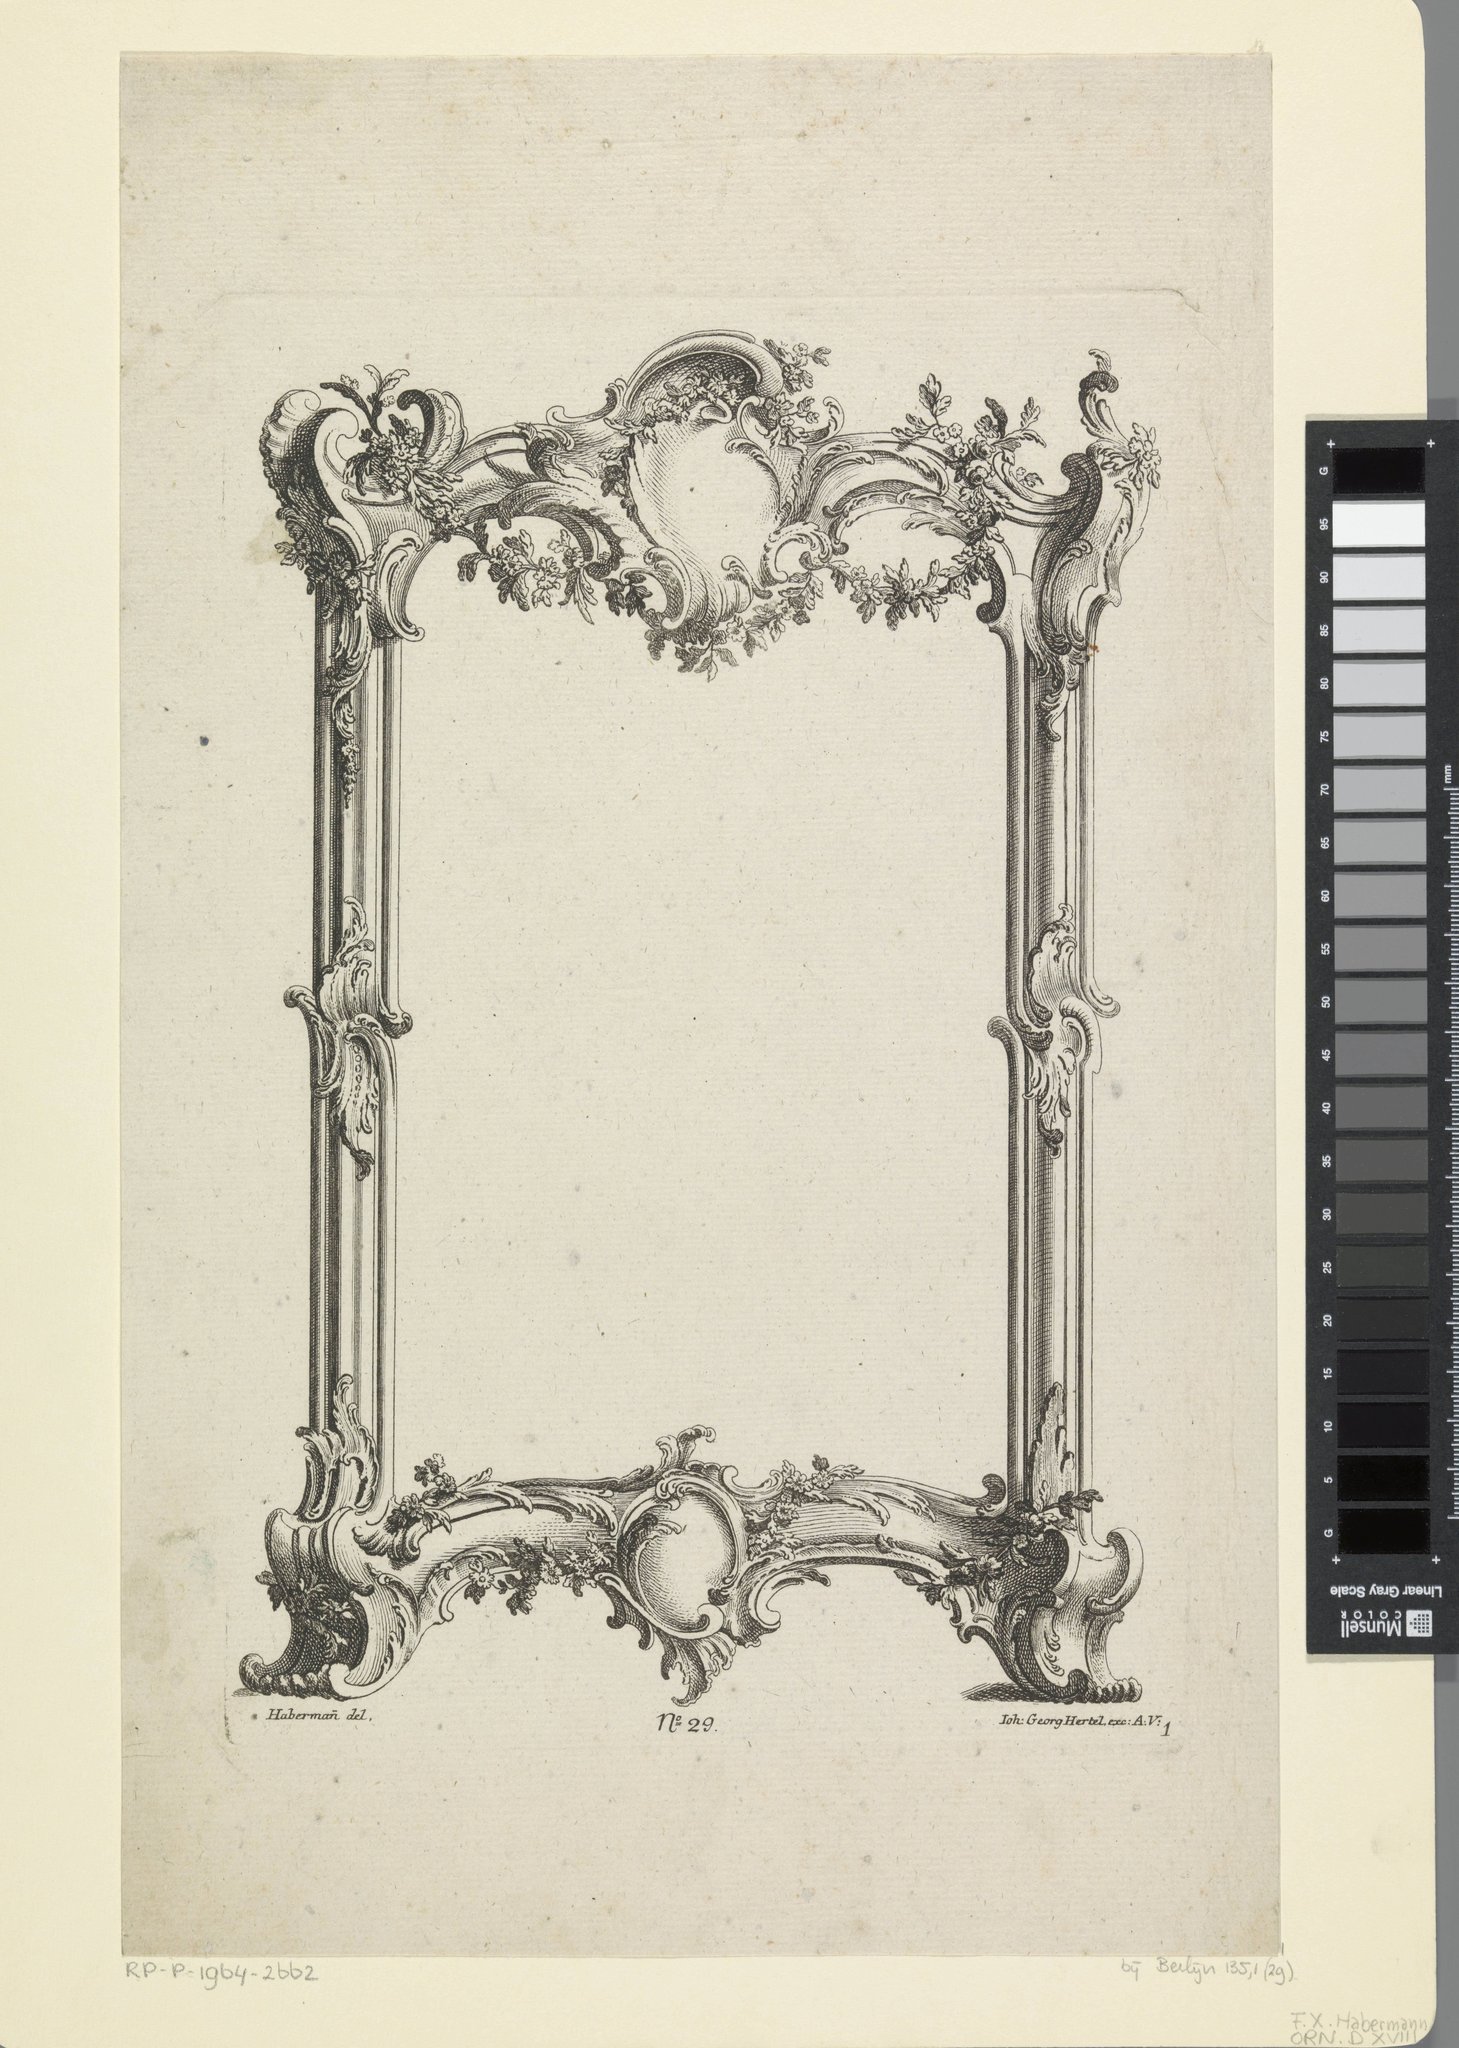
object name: ornament print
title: Rocaille lijst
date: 1731-1775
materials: paper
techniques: etching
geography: augsburg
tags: rocaille ornament, ornaments ~ art (+ framing decorations)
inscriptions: collector's mark: Lugt 2228, collector's mark: Lugt 2760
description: Rocaille omlijsting met bloemen, staande rechthoek. Uitgeversnummer 29.